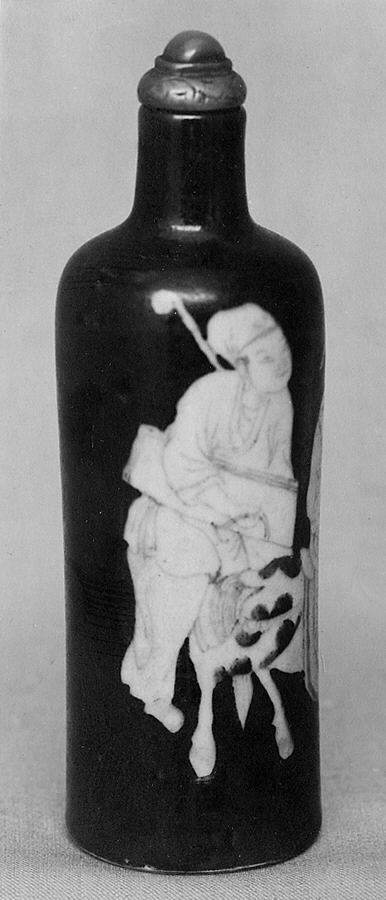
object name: snuff bottle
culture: chinese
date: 1723-1735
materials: porcelain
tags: men,horses